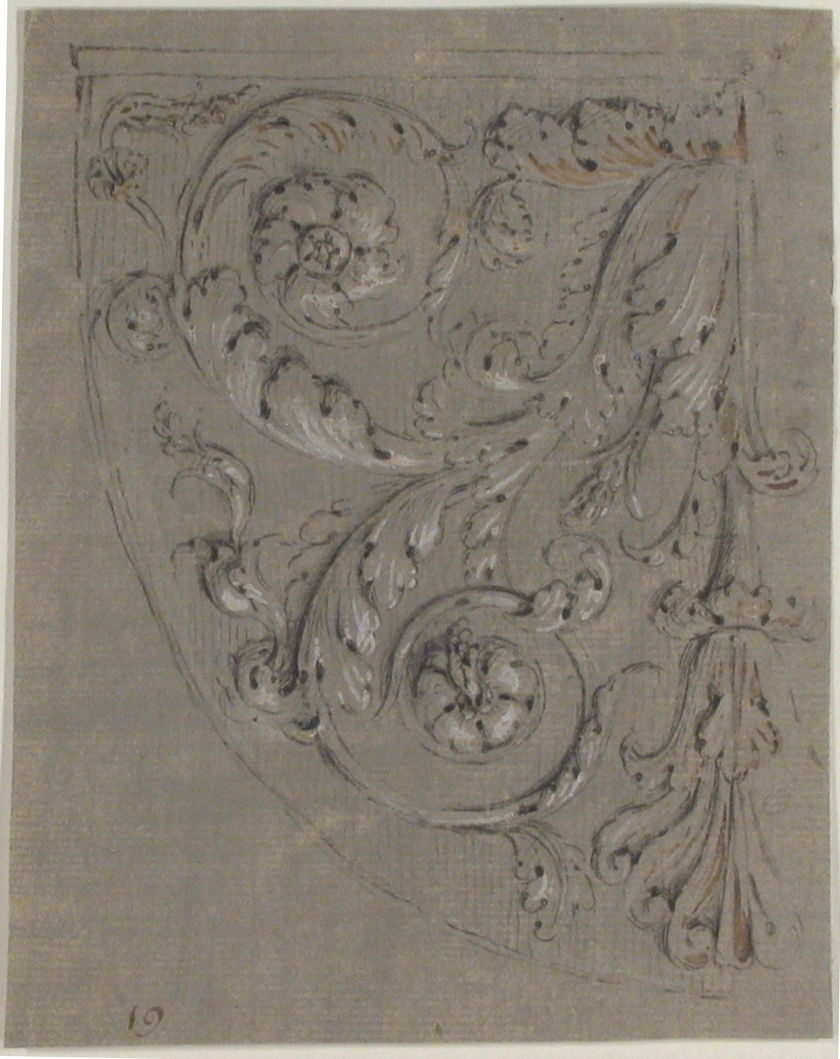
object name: drawing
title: Design for Sculpted Ornament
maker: anonymous, french, 19th century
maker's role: artist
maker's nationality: french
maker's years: 1800-1900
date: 1825-1850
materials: chalk, graphite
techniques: heightening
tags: ornament